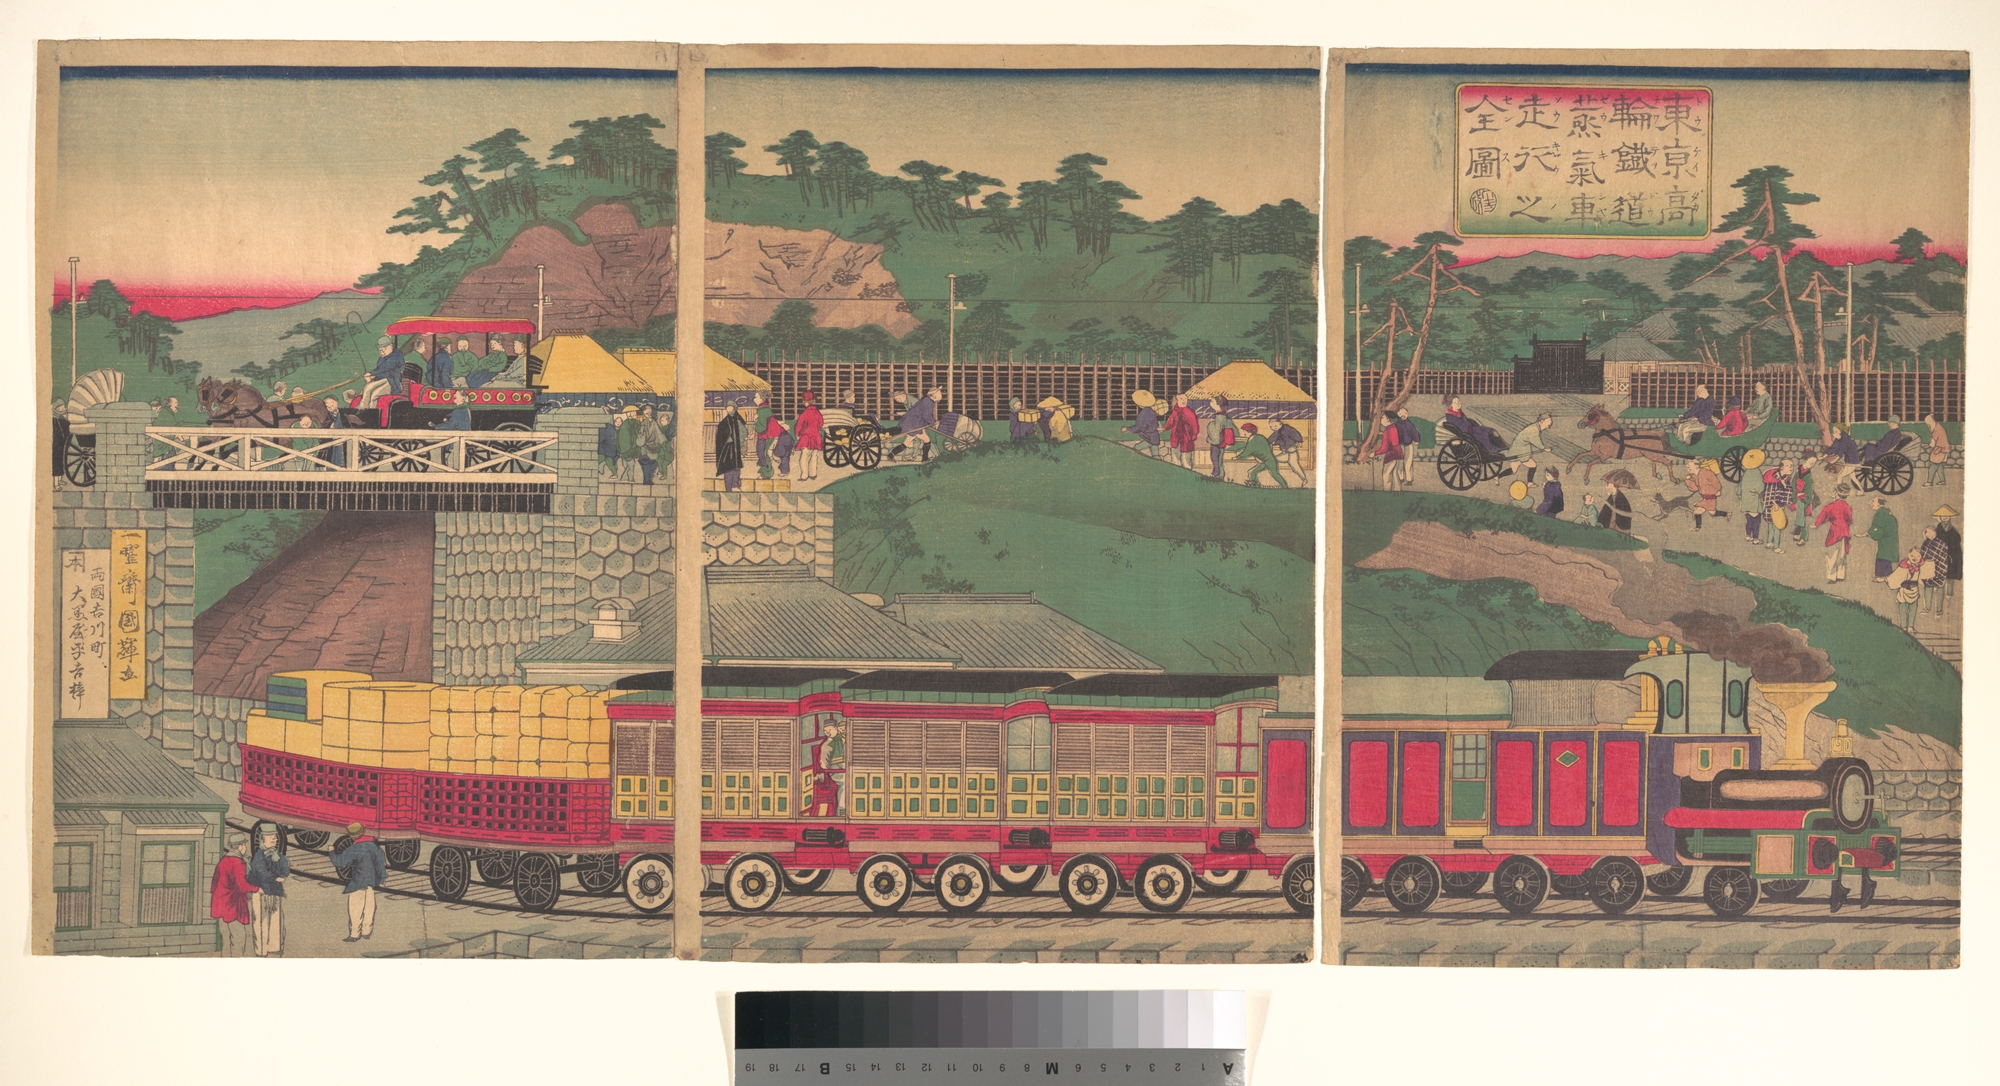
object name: print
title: Tokyo /Takanawa Steam Railway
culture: japanese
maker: utagawa kuniteru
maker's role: artist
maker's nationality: japanese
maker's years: 1830-1874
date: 1879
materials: ink, paper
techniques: woodblock print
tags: bridges,railways,trees,crowd,trains